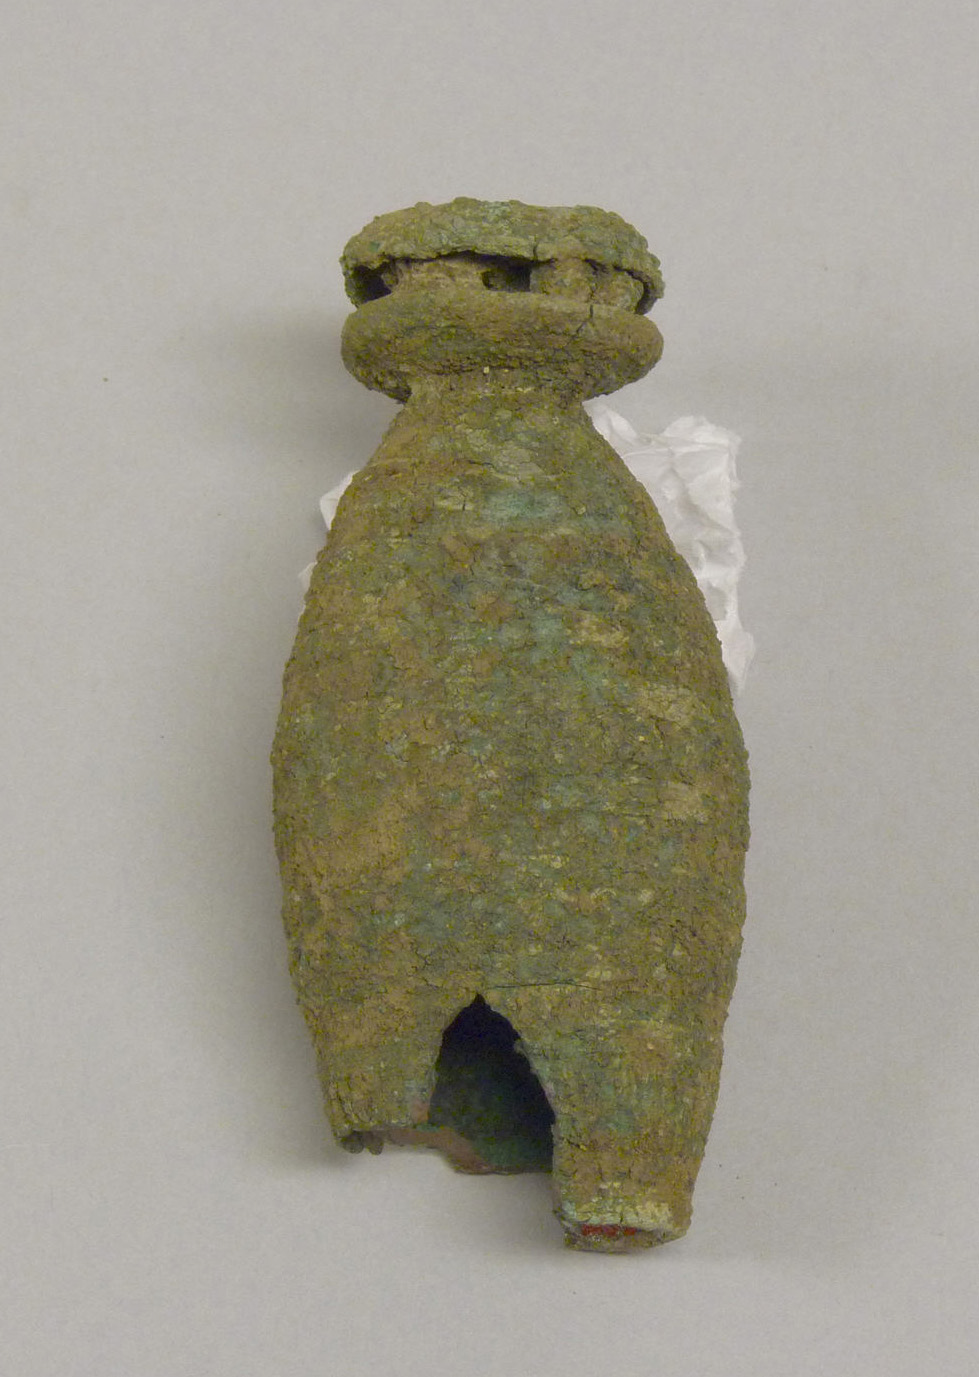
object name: handle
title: Handle (?) with Pellet Bells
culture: vietnamese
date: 500 BCE-300 CE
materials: bronze